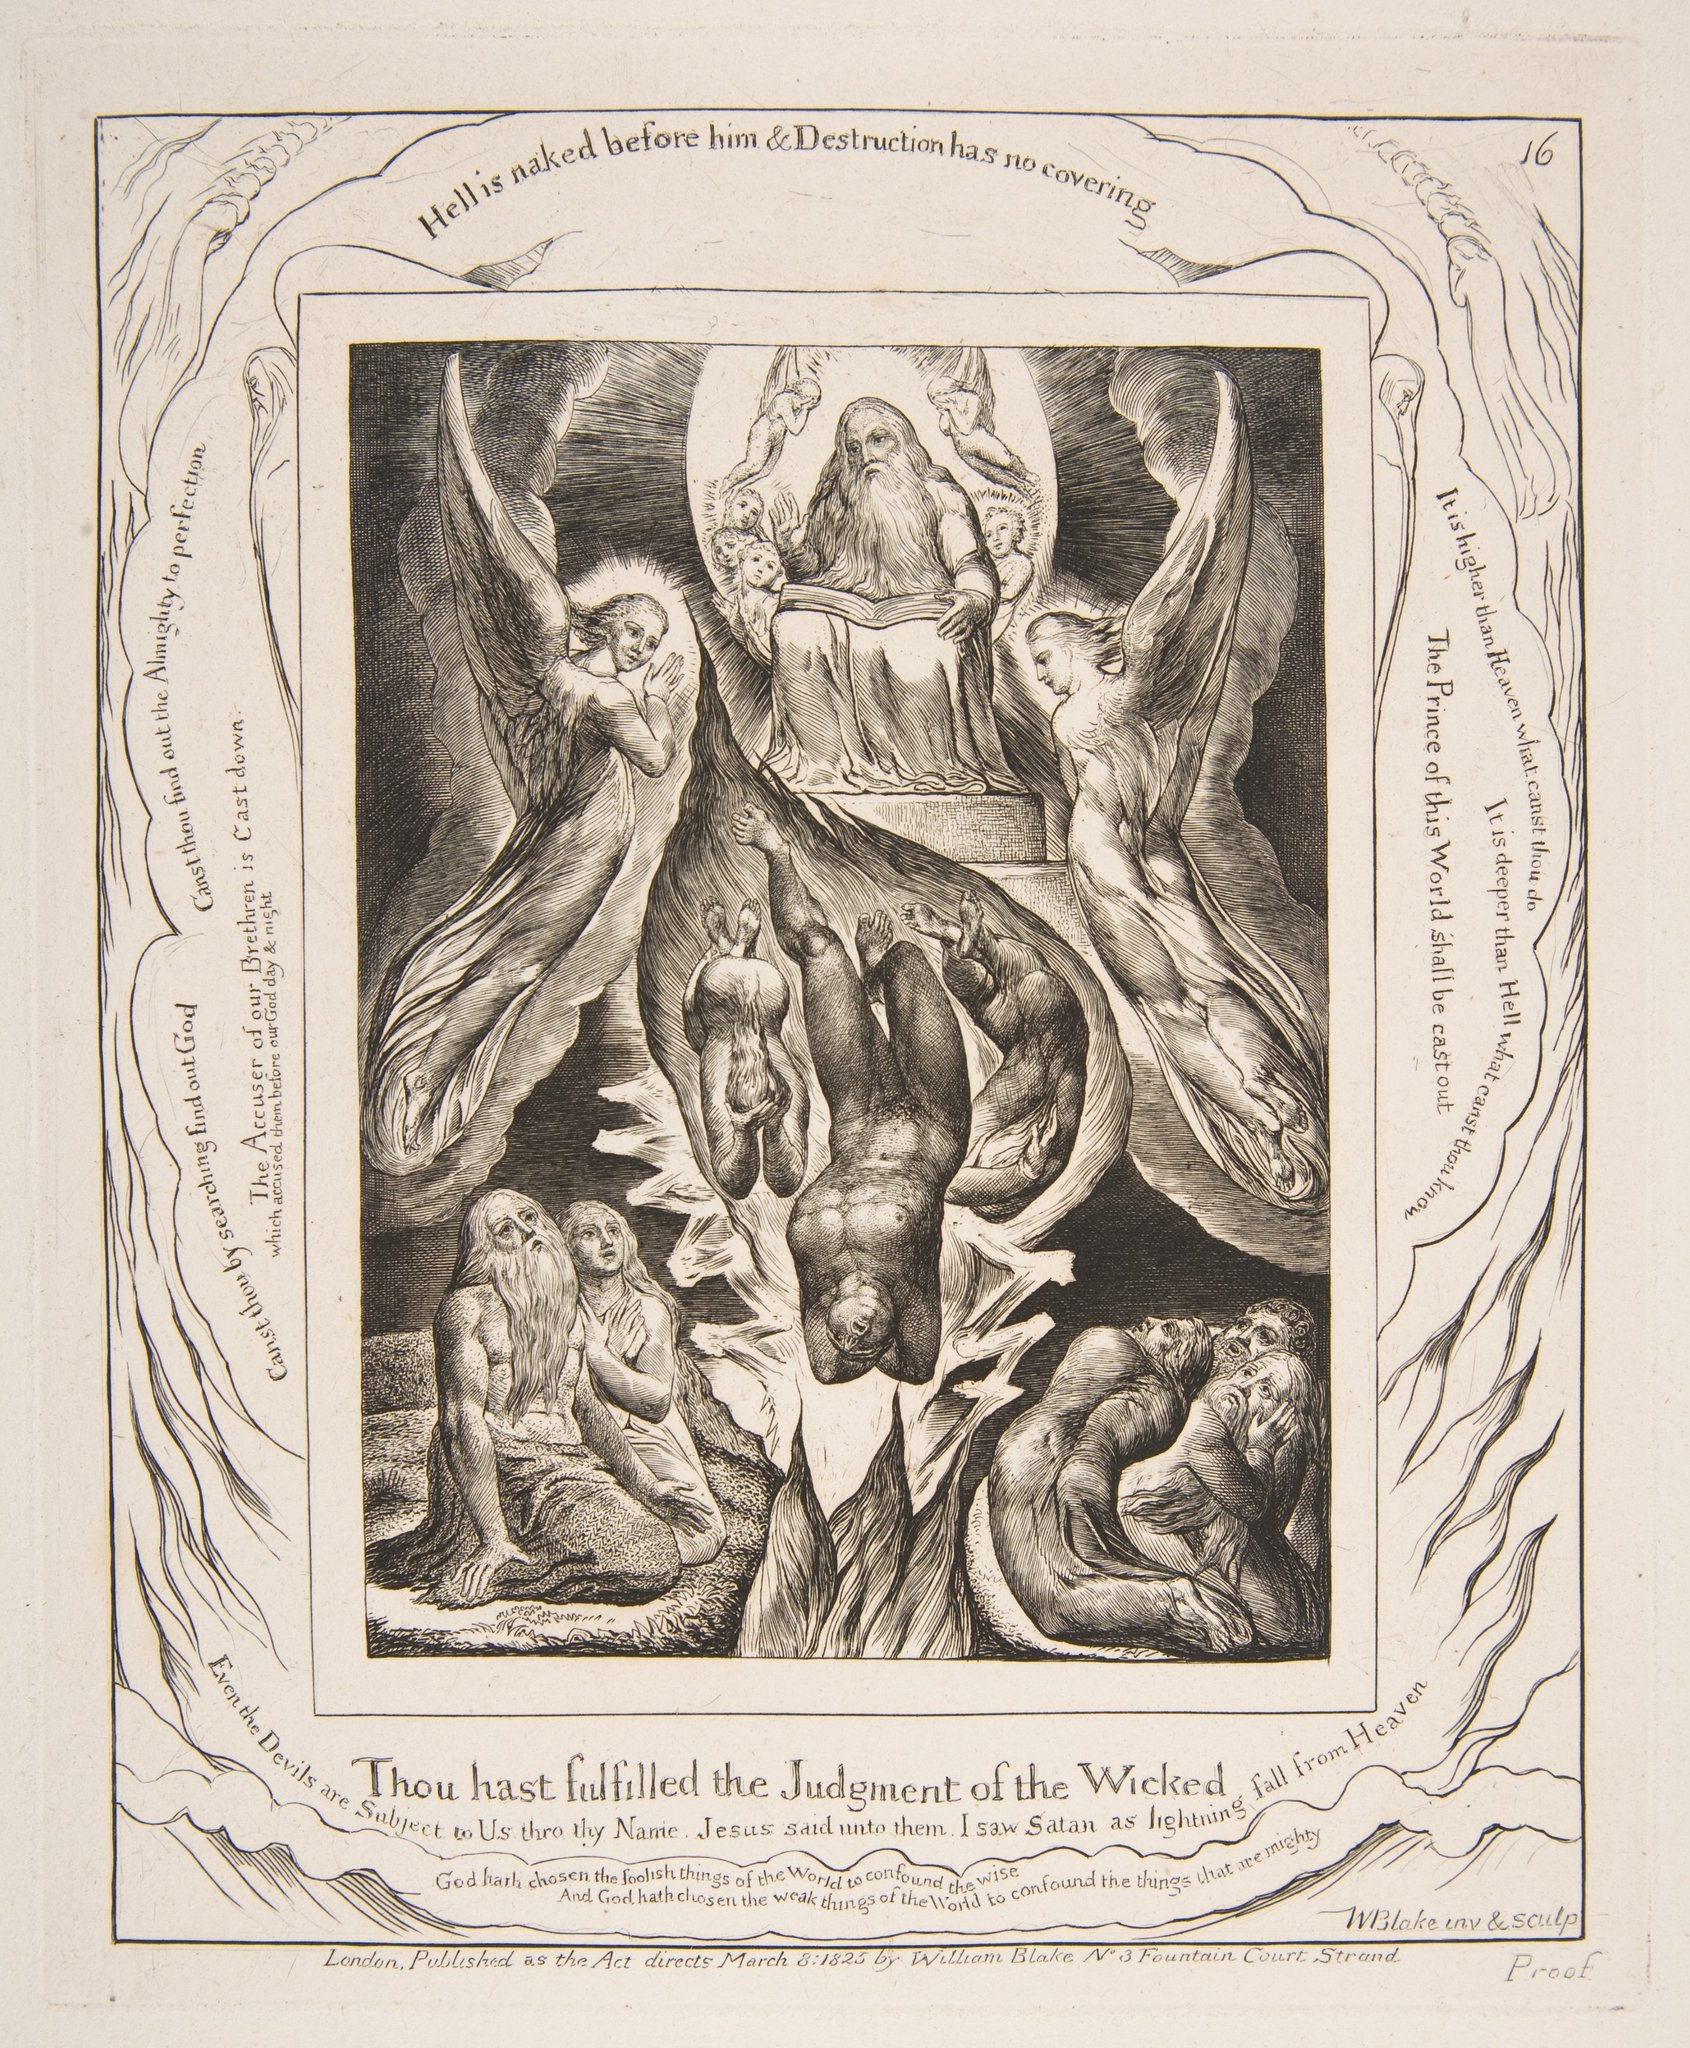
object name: print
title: The Fall of Satan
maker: william blake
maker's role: artist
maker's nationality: british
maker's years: 1757-1827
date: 1825-1826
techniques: engraving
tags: men,women,angels,devil